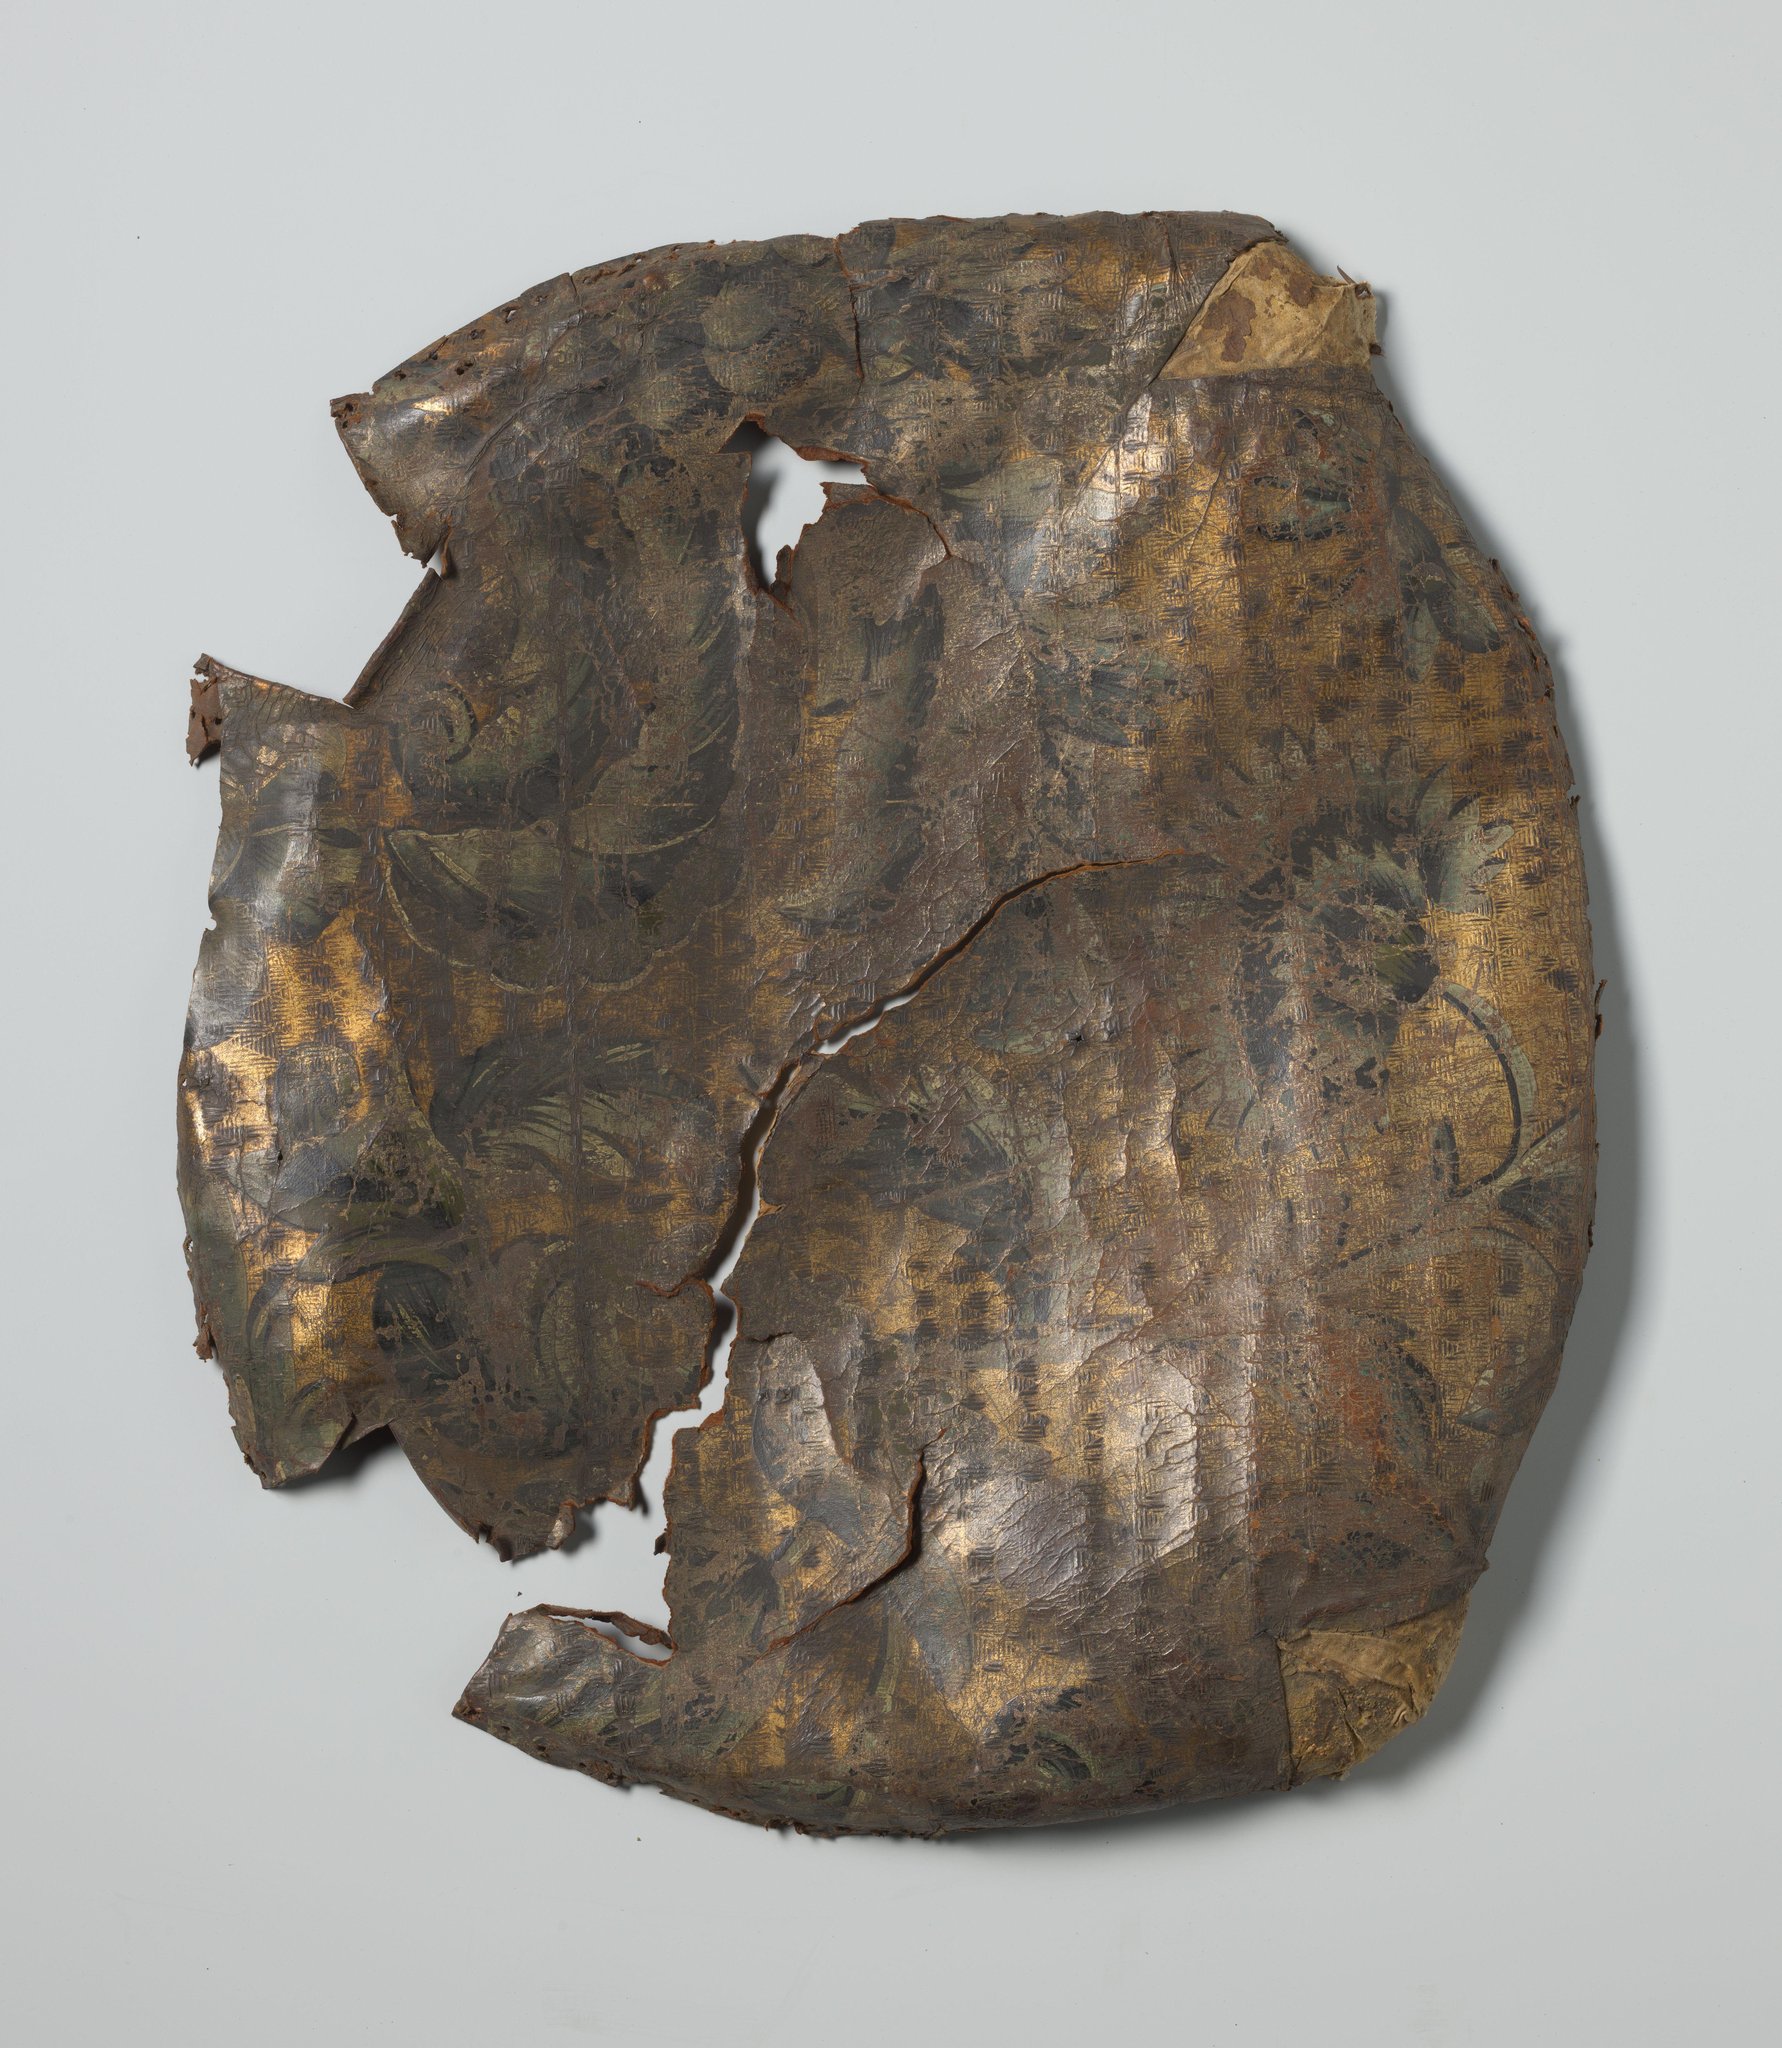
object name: stoelbekleding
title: Stoelbekleding (zitting) van goudleer met patroon van bloemen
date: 1700-1800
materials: gilt leather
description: Stoelbekleding (zitting) van goudleer met patroon van bloemen.